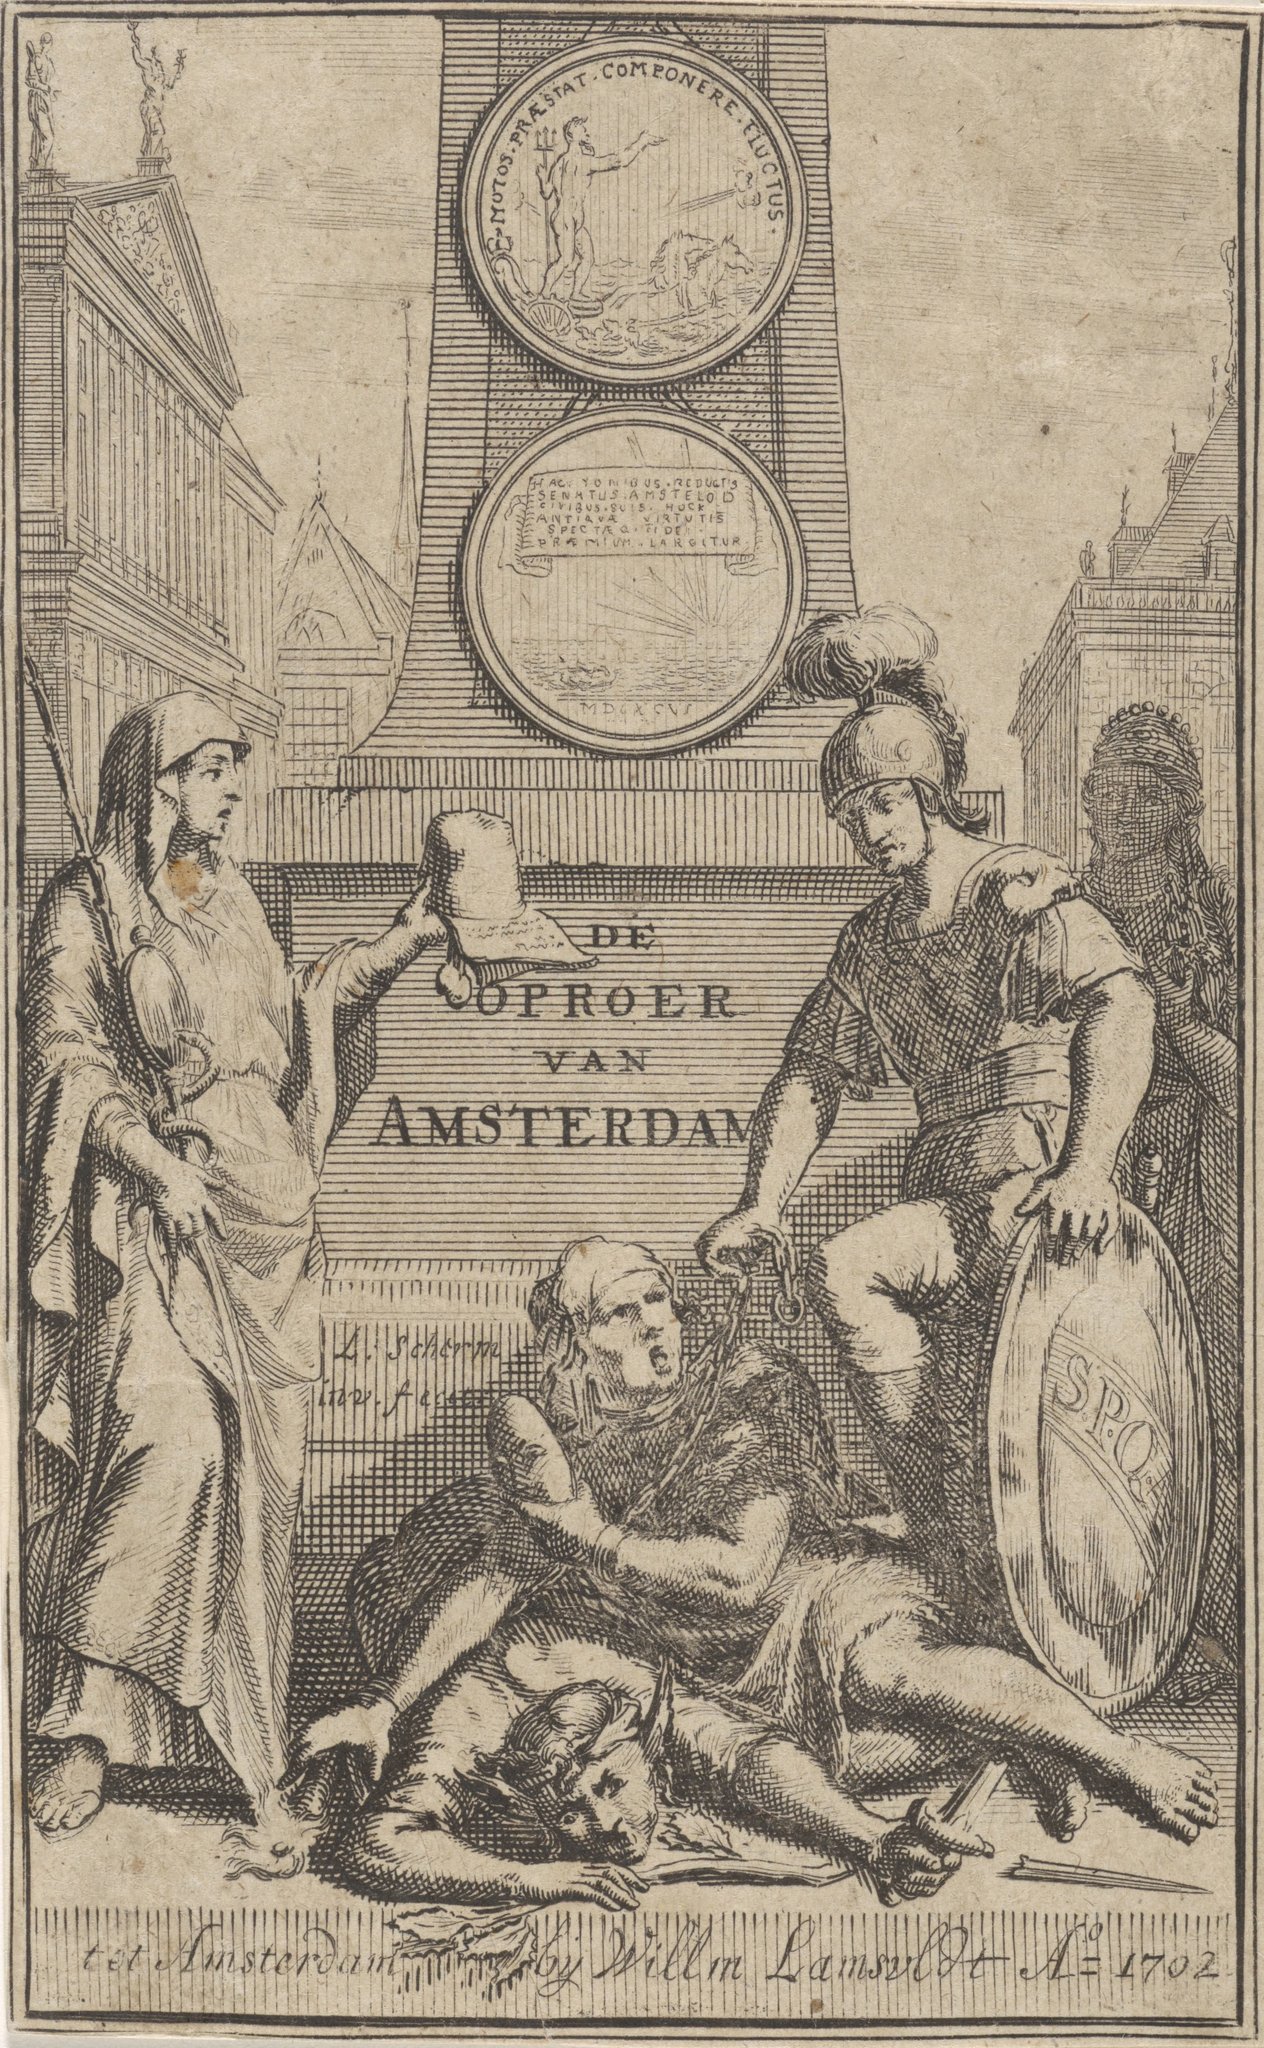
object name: print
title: Allegorische figuren voor een obelisk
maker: laurens scherm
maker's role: draughtsman, print maker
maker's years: 1671-1702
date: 1702-1733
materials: paper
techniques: engraving, etching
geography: amsterdam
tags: unsuccessful revolution or revolt, suppression of revolutionary activity, obelisk, needle, title-page, townhall, the soldier; the soldier's life, prisoner with hands bound, prudentia (prudence) as roman personification, amsterdam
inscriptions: collector's mark: Lugt 2760, collector's mark: Lugt 2166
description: Allegorische voorstelling voor een obelisk waarin twee oproerkraaiers (van het Aansprekersoproer uit 1696) door een soldaat worden geketend en onderdrukt. Links staat Voorzichtigheid met een spiegel en een slang. Rechts staat de soldaat, op zijn schild staat de afkorting S.P.Q.A. (de senaat en het volk van Amsterdam). In zijn linkerhand heeft hij ketenen, waarmee hij de man voor hem geboeid heeft. Onder deze man ligt een man met ezelsoren en een gebroken dolk. Op de obelisk zijn twee medaillons met zeesymboliek te zien: boven Neptunus op zijn wagen en onder de zee. Links op de achtergrond het Stadhuis op de Dam.